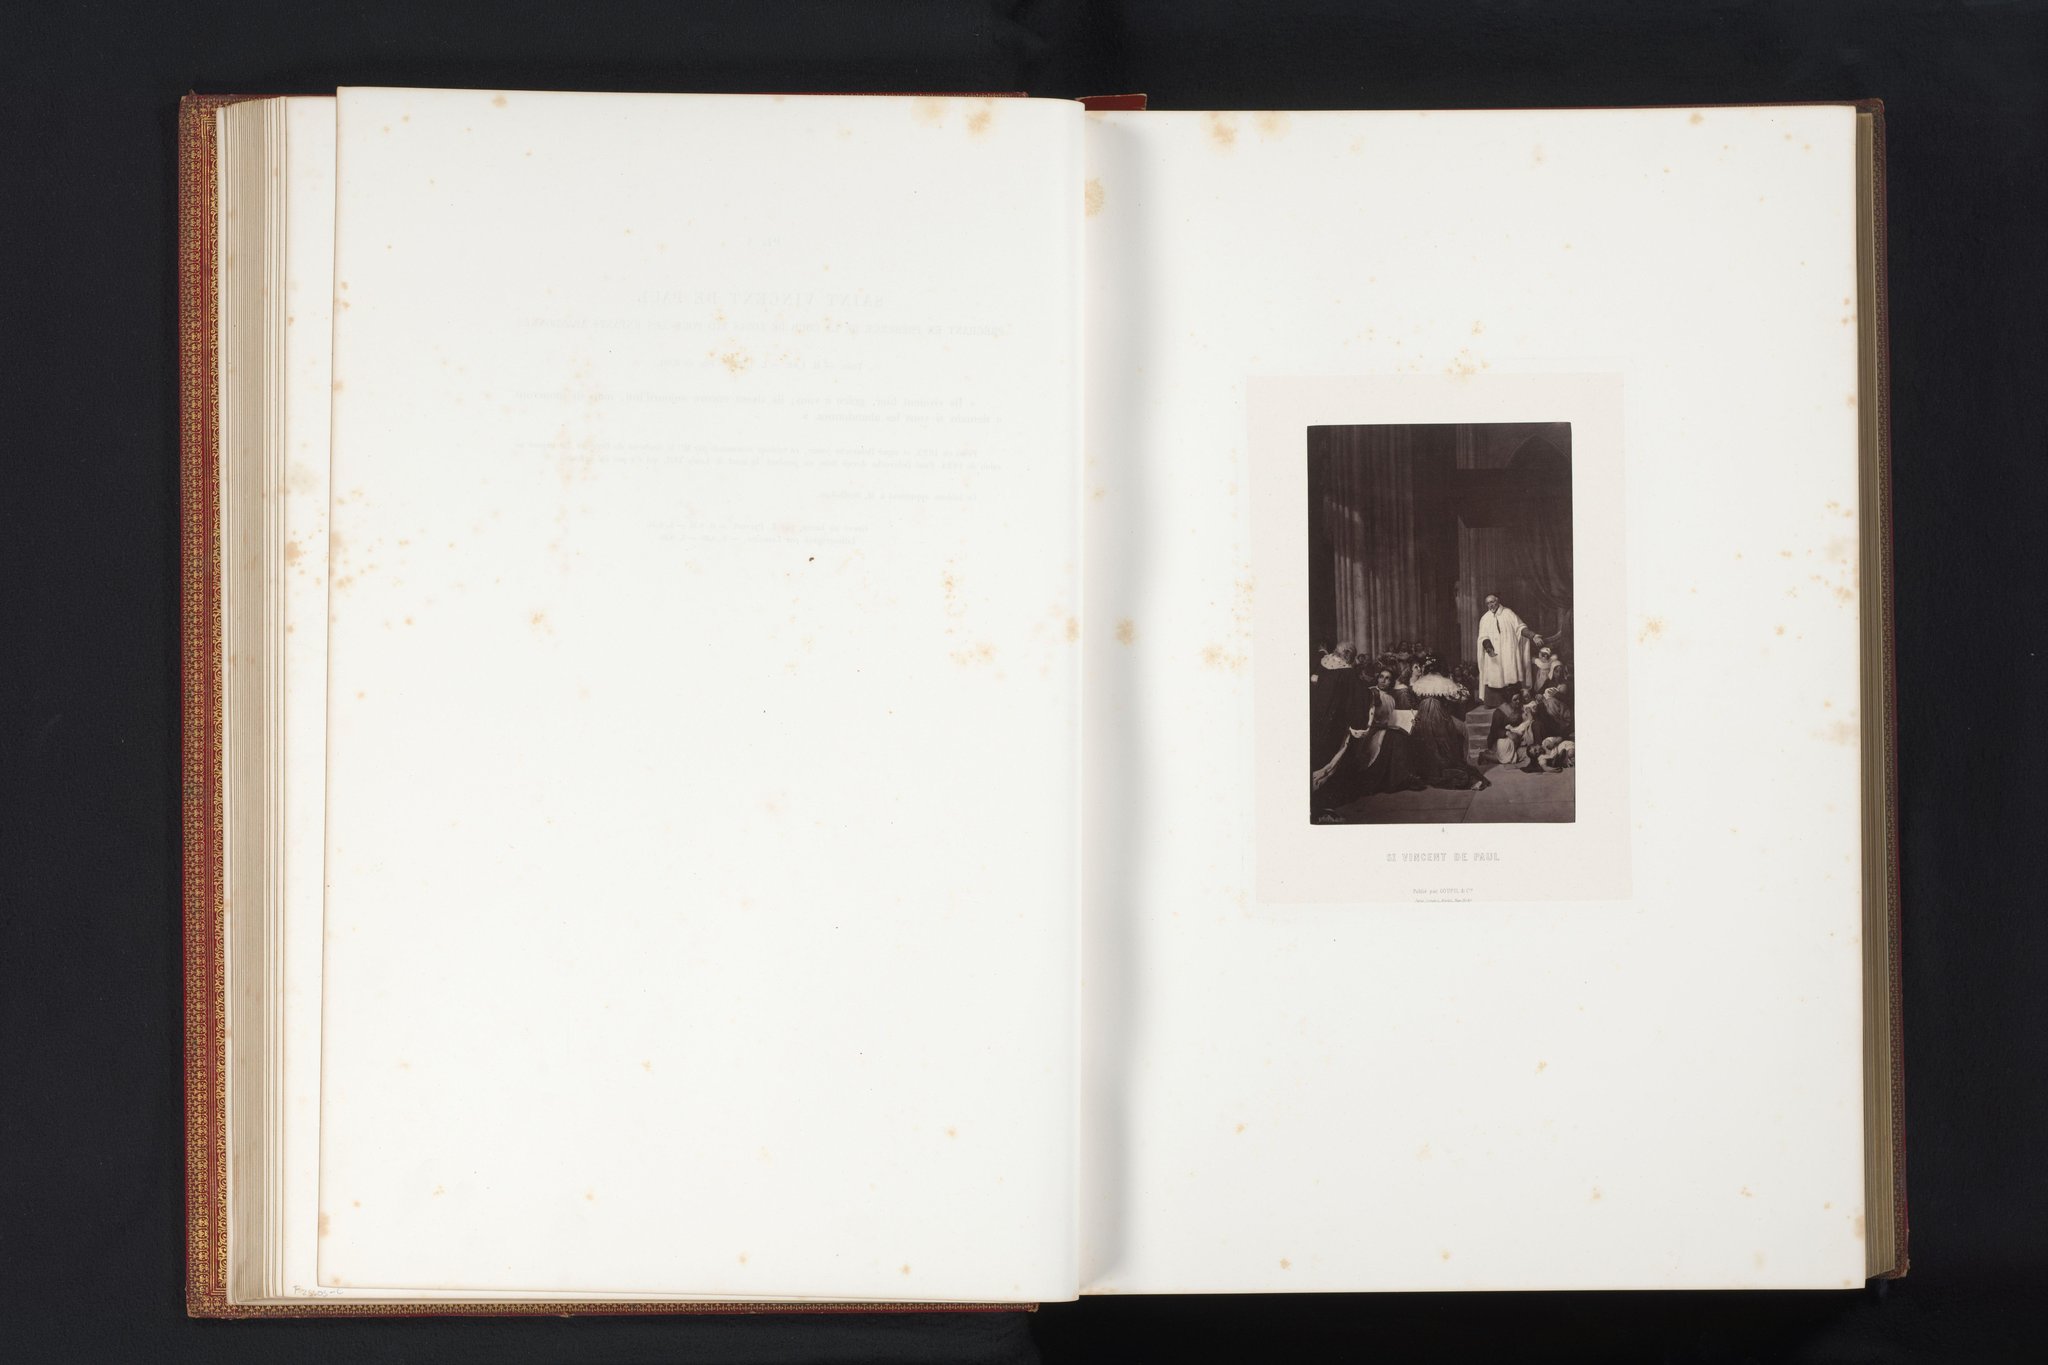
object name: page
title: Saint Vincent de Paul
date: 1853-1858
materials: paper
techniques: albumen print, engraving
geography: paris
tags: priest, preaching (in general)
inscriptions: check stamp: ‘Goupil & Cie’